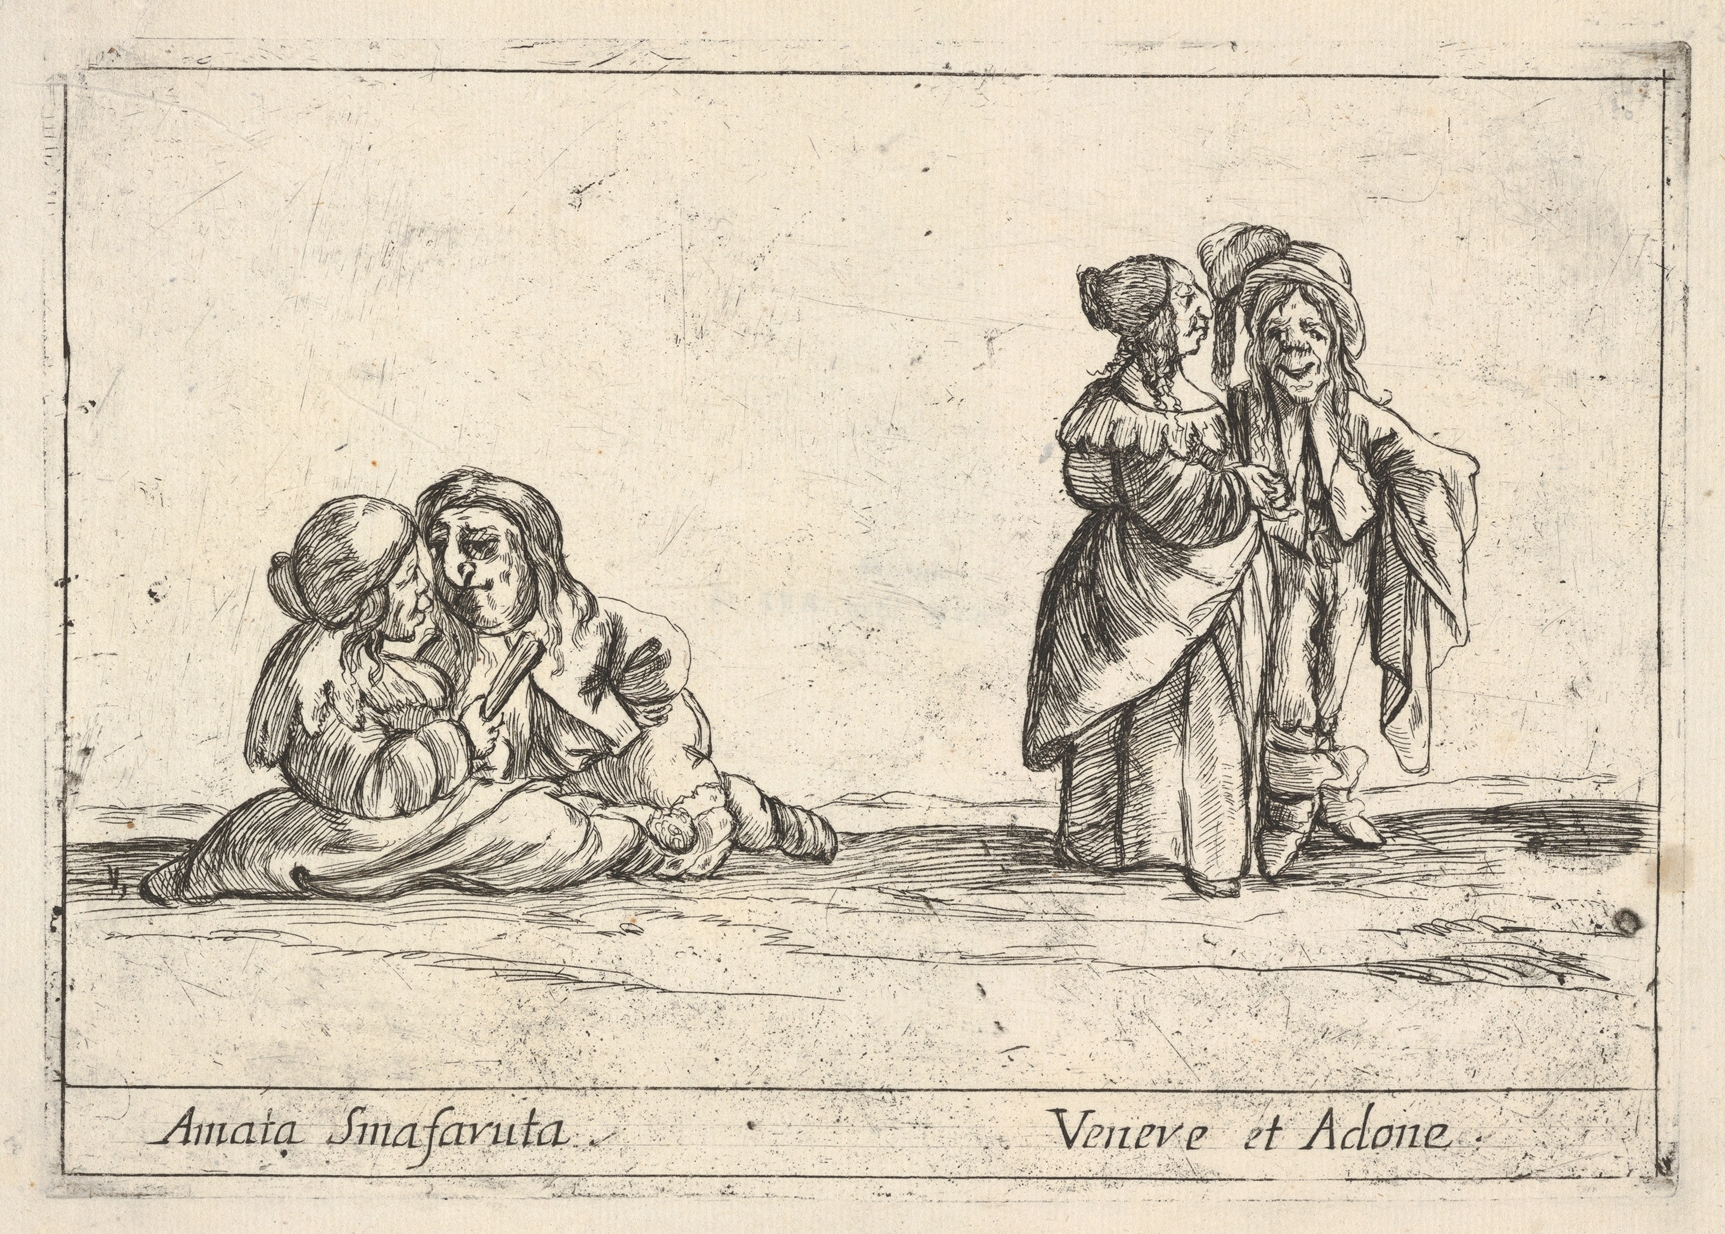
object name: print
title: Callot figures; two seated dwarf lovers to left, the woman holding a fan, an old dwarf woman, in profile towards the right, standing with a dwarf man with long hair to right, from "Six grotesques" (Six pièces de figures grotesques)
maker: agostino mitelli ii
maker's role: artist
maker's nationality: italian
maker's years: 1671-1696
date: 1684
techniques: etching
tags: fans,lovers,women